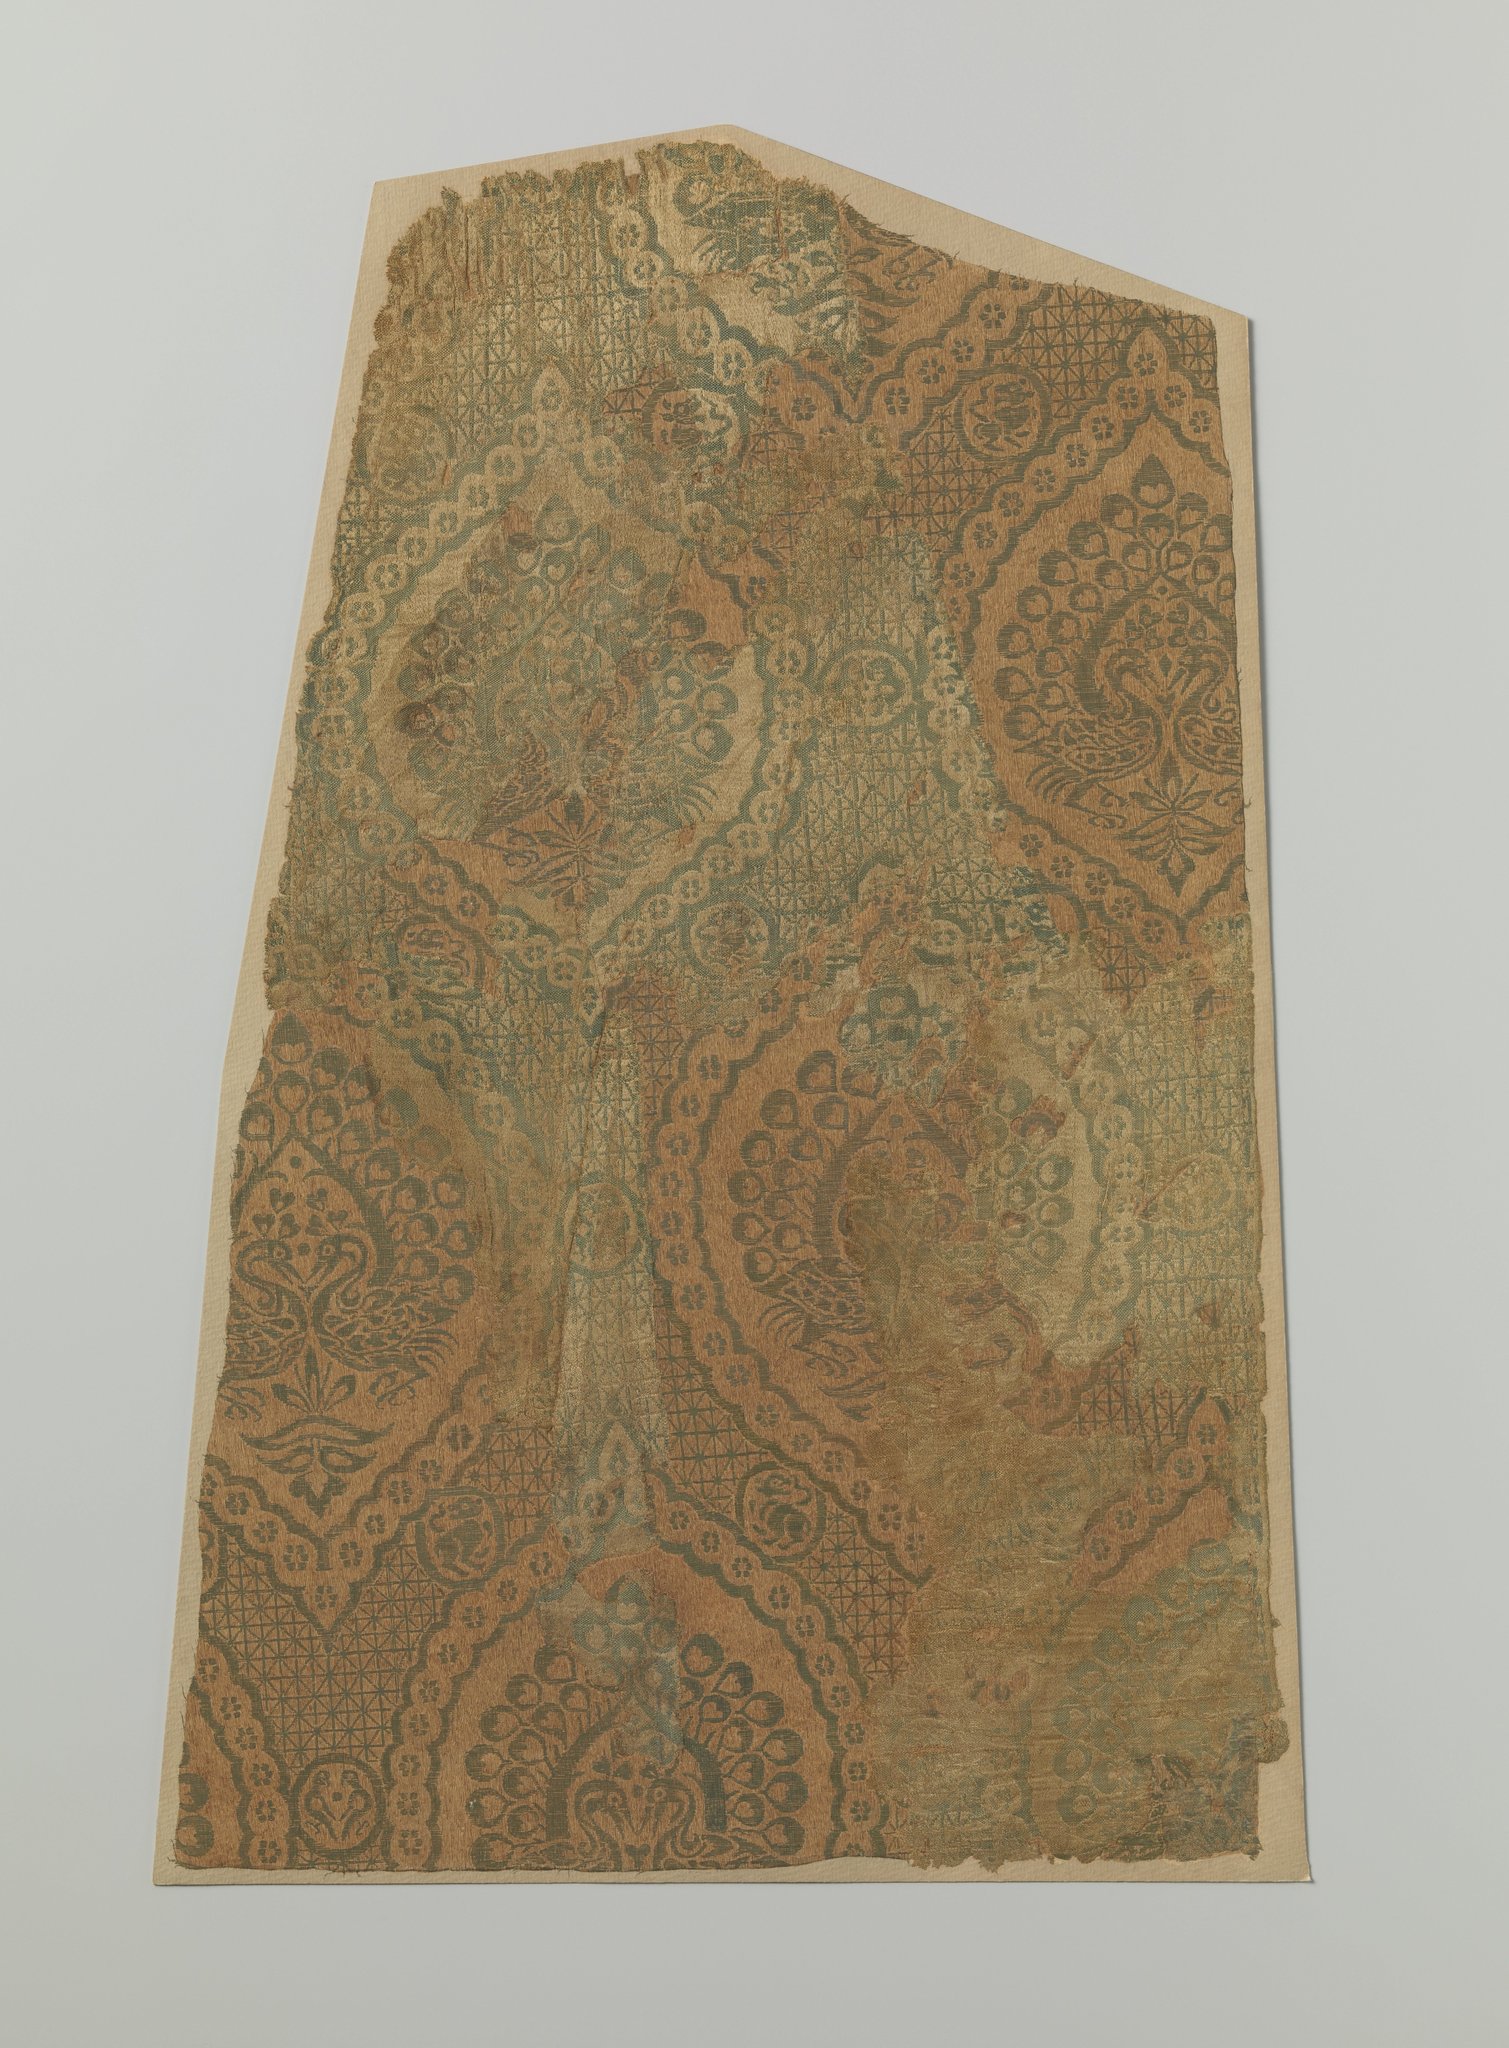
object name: silk textile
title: Fragment zijdeweefsel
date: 1200-1299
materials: silk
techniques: embroidery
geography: krefeld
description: Fragment van oranje-rode zijde met zich herhalend patroon in groen van naar elkaar toegewende pronkende pauwen in spitsovalen. De spitsovalen zijn onderling verbonden met kleine medaillons waarin gestileerde dierfiguren. De grond rondom heeft een netwerkpatroon. Patroon is bijgetekend.